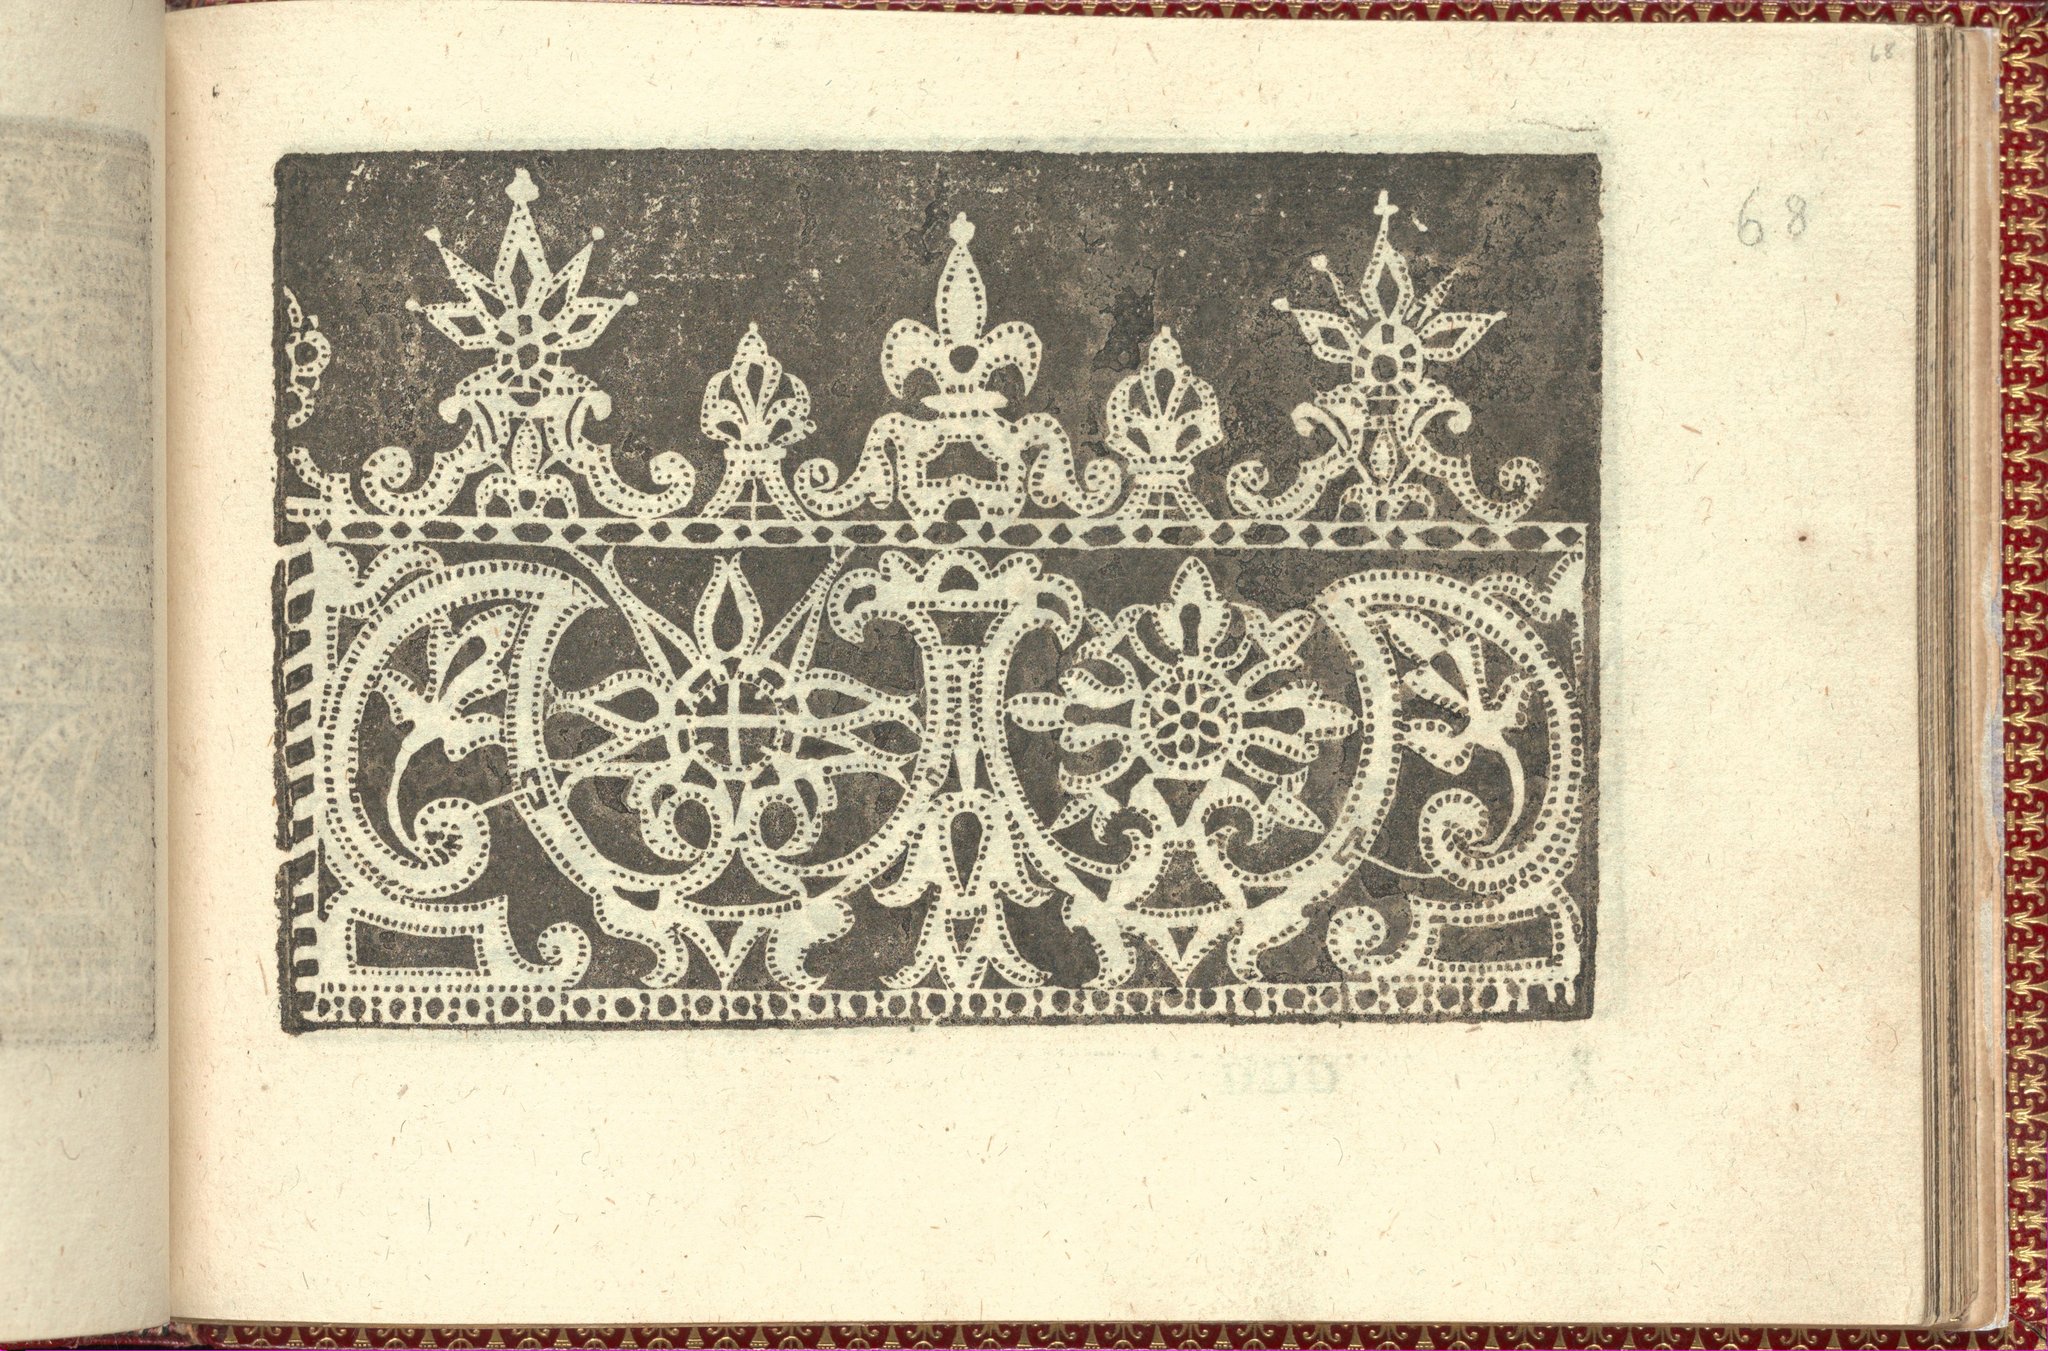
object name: book print ornament architecture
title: Corona delle Nobili et Virtuose Donne: Libro I-IV, page 68 (recto)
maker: cesare vecellio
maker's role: publisher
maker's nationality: italian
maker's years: 1521-1601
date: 1601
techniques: woodcut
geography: italy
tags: flowers